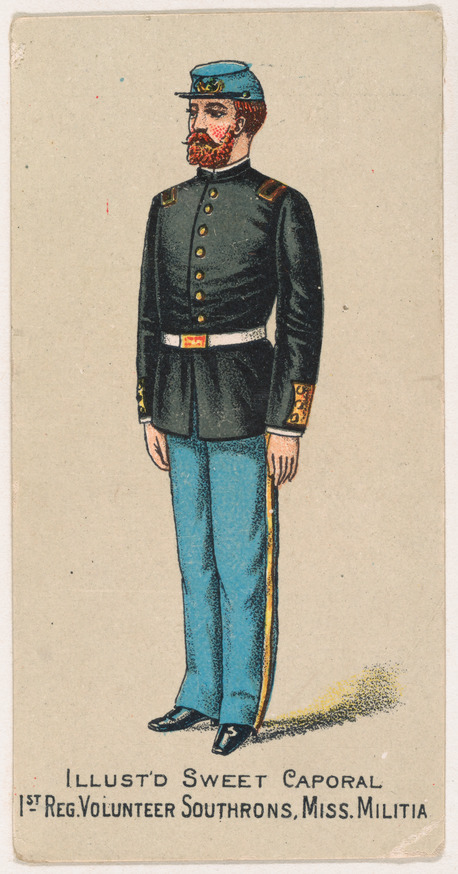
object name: print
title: 1st Regiment, Volunteer Southrons, Mississippi Militia, from the Military Series (N224) issued by Kinney Tobacco Company to promote Sweet Caporal Cigarettes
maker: kinney brothers tobacco company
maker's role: publisher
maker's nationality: american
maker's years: 1869-2011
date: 1888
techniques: color lithograph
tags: military,men